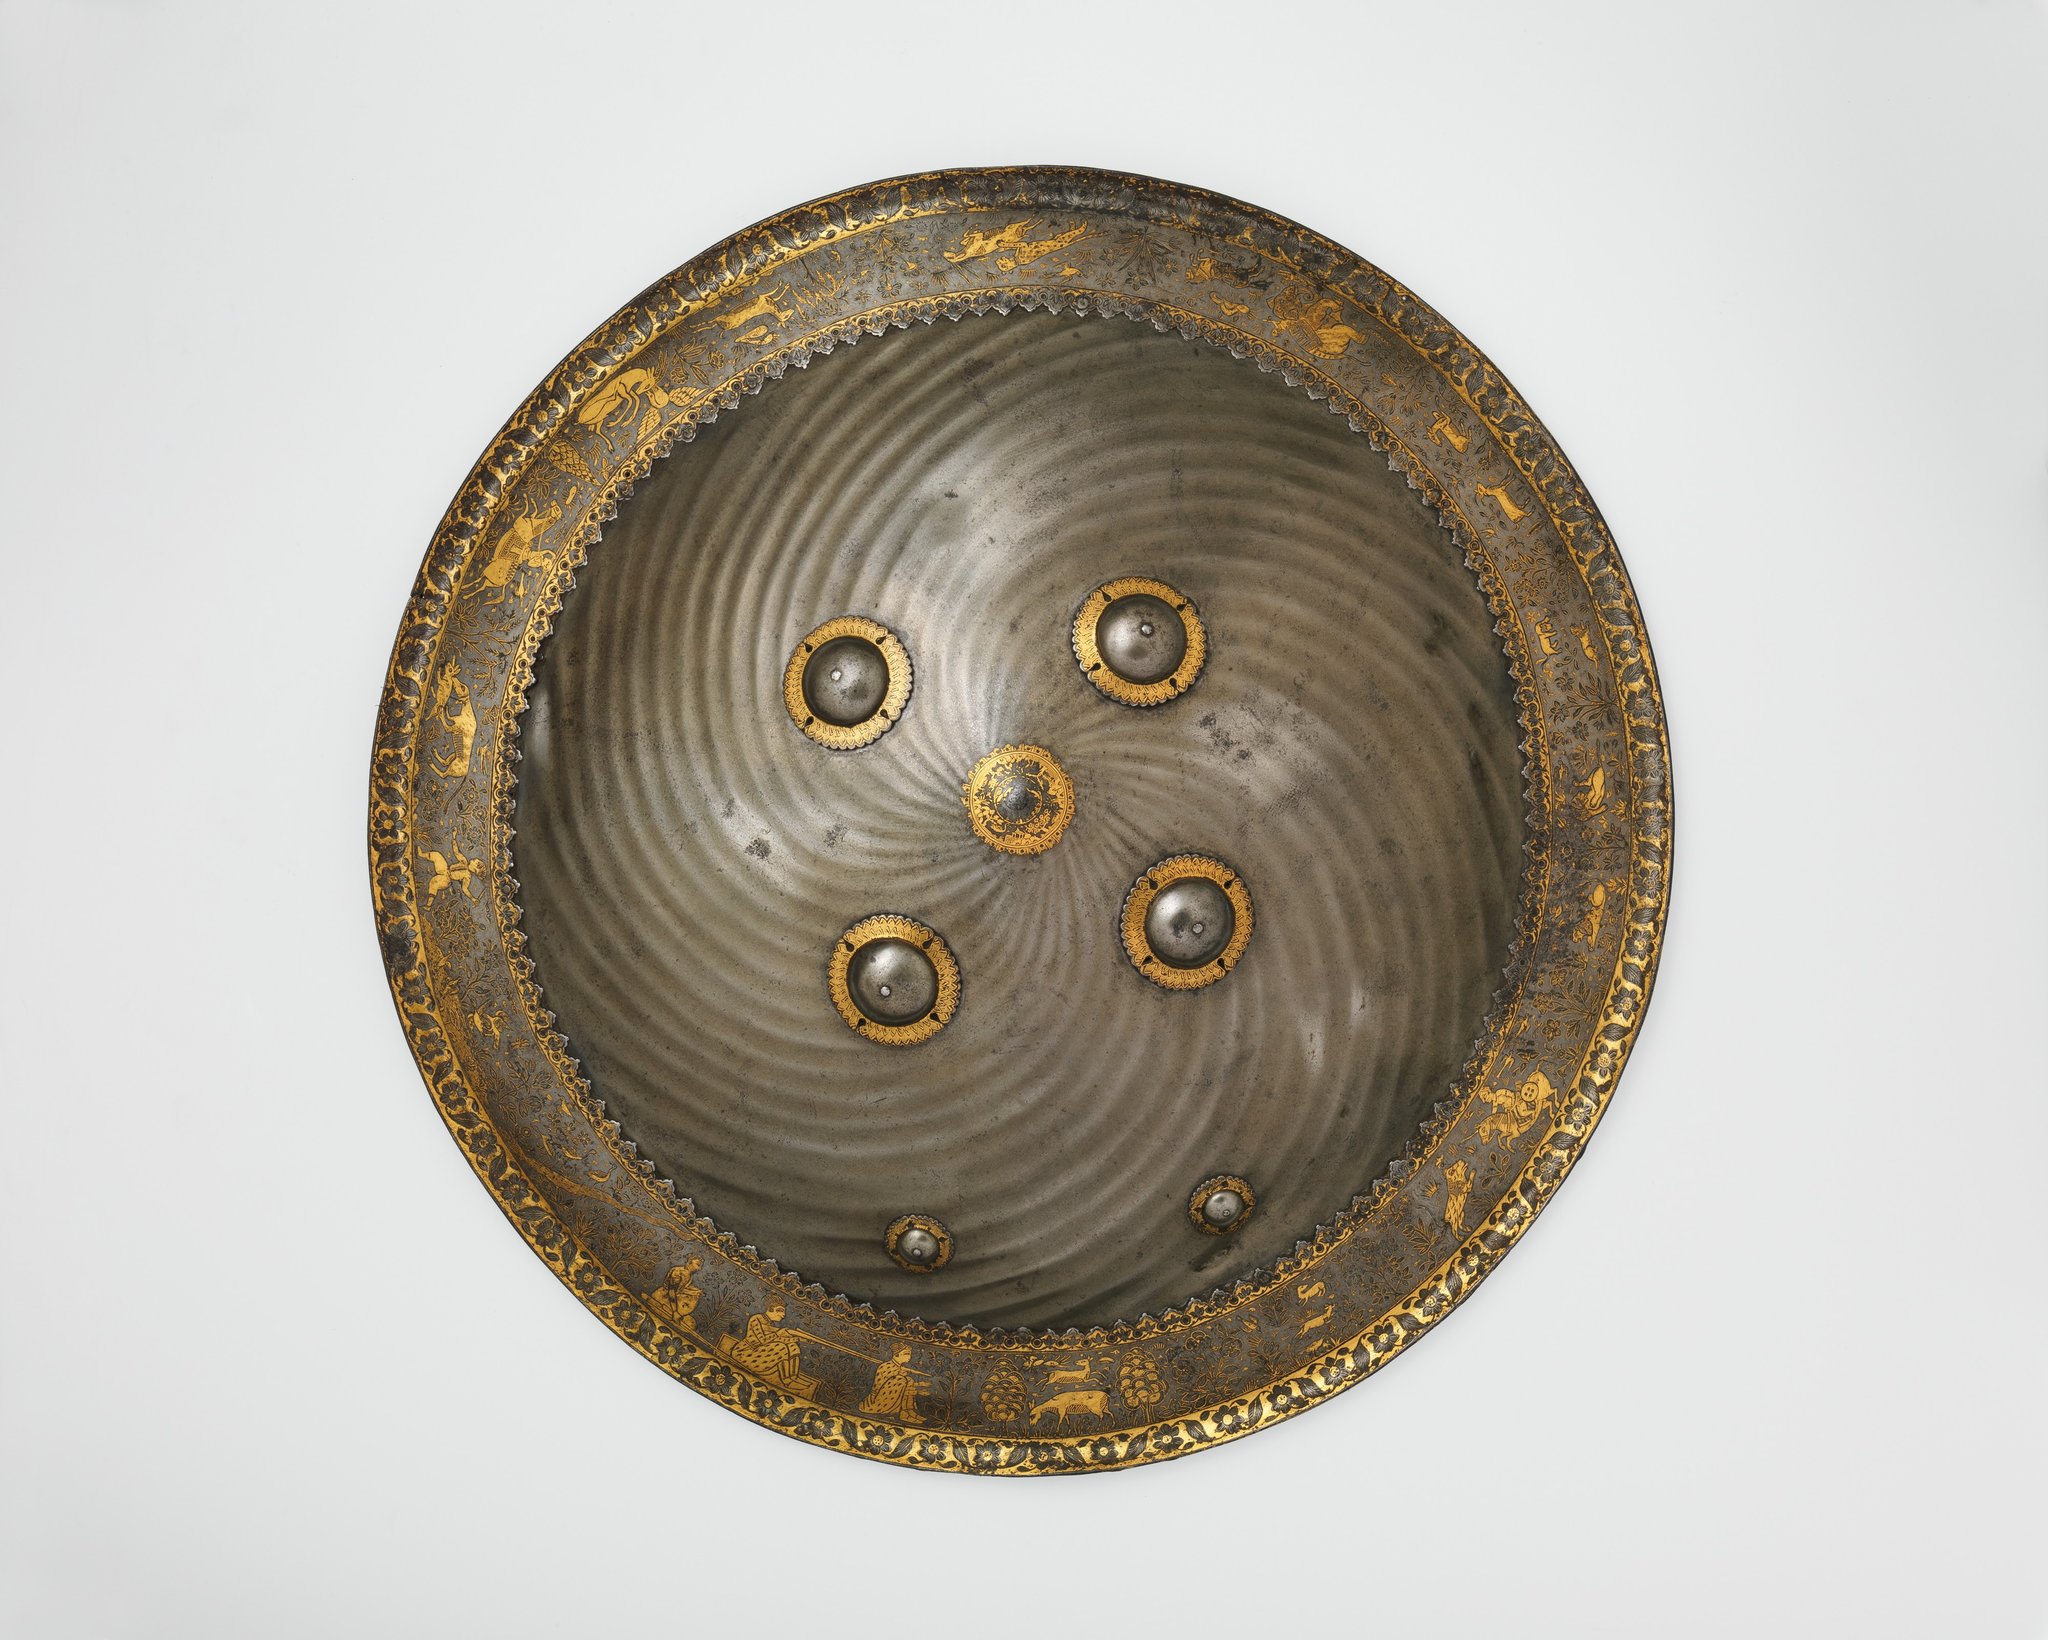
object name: shield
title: Shield with Hunting and Landscape Vignettes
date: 1651-1700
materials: gold, steel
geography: india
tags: shields,men,hunting,horses,lions